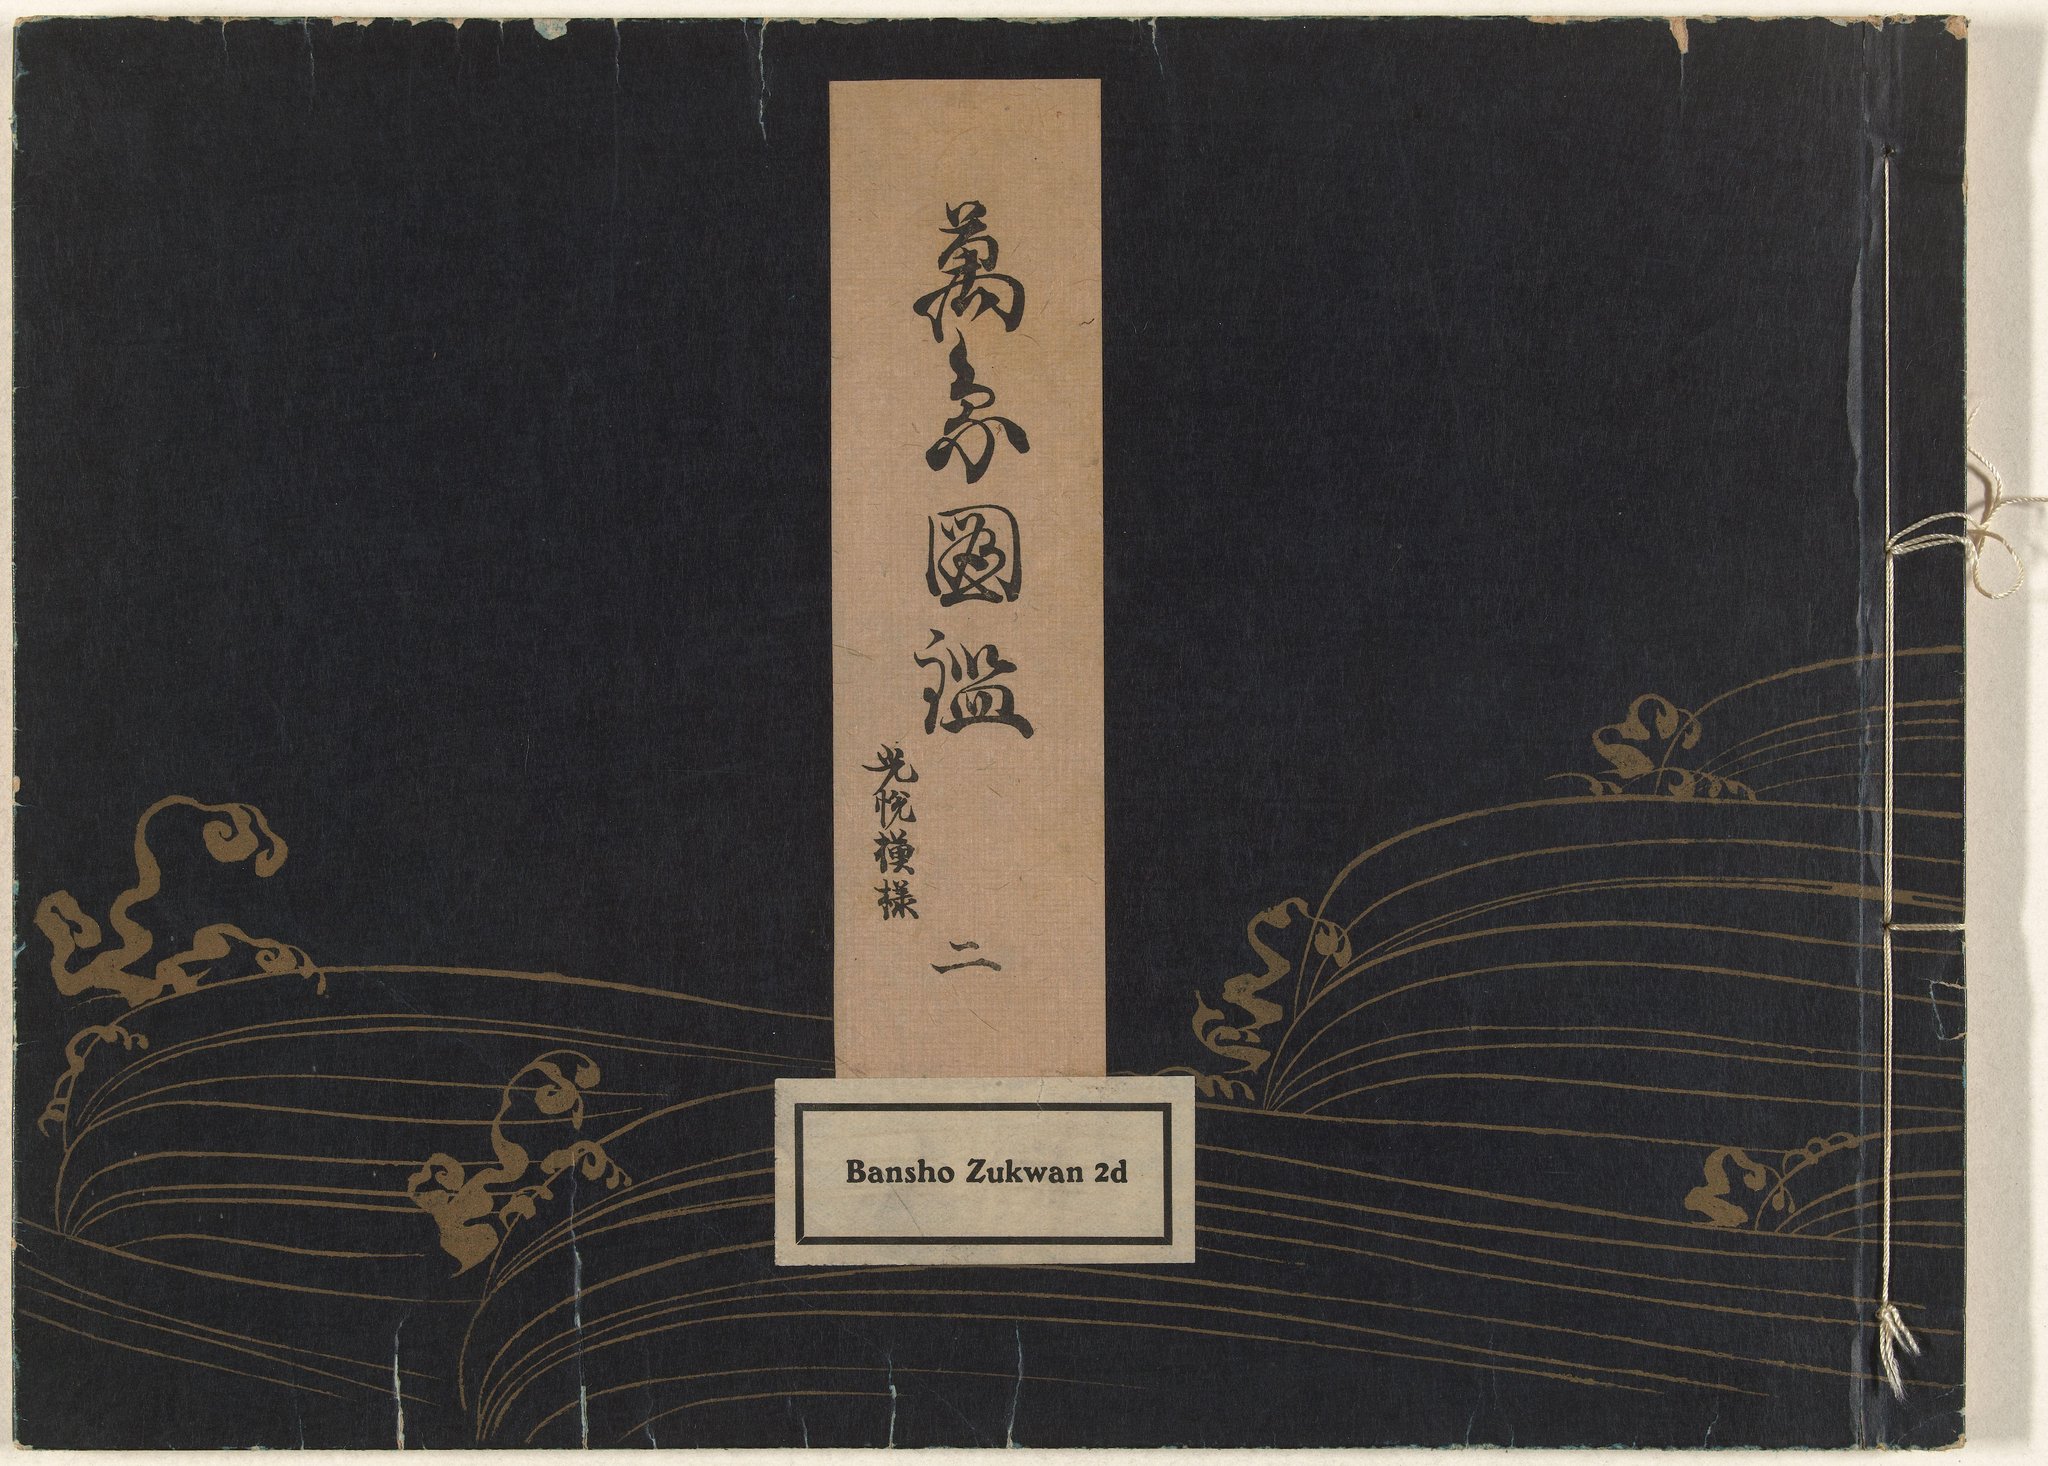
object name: book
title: Prentenboek der natuur - deel twee - Koetsu`s ontwerpen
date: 1901-1908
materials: paper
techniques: woodcut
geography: japan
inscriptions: date